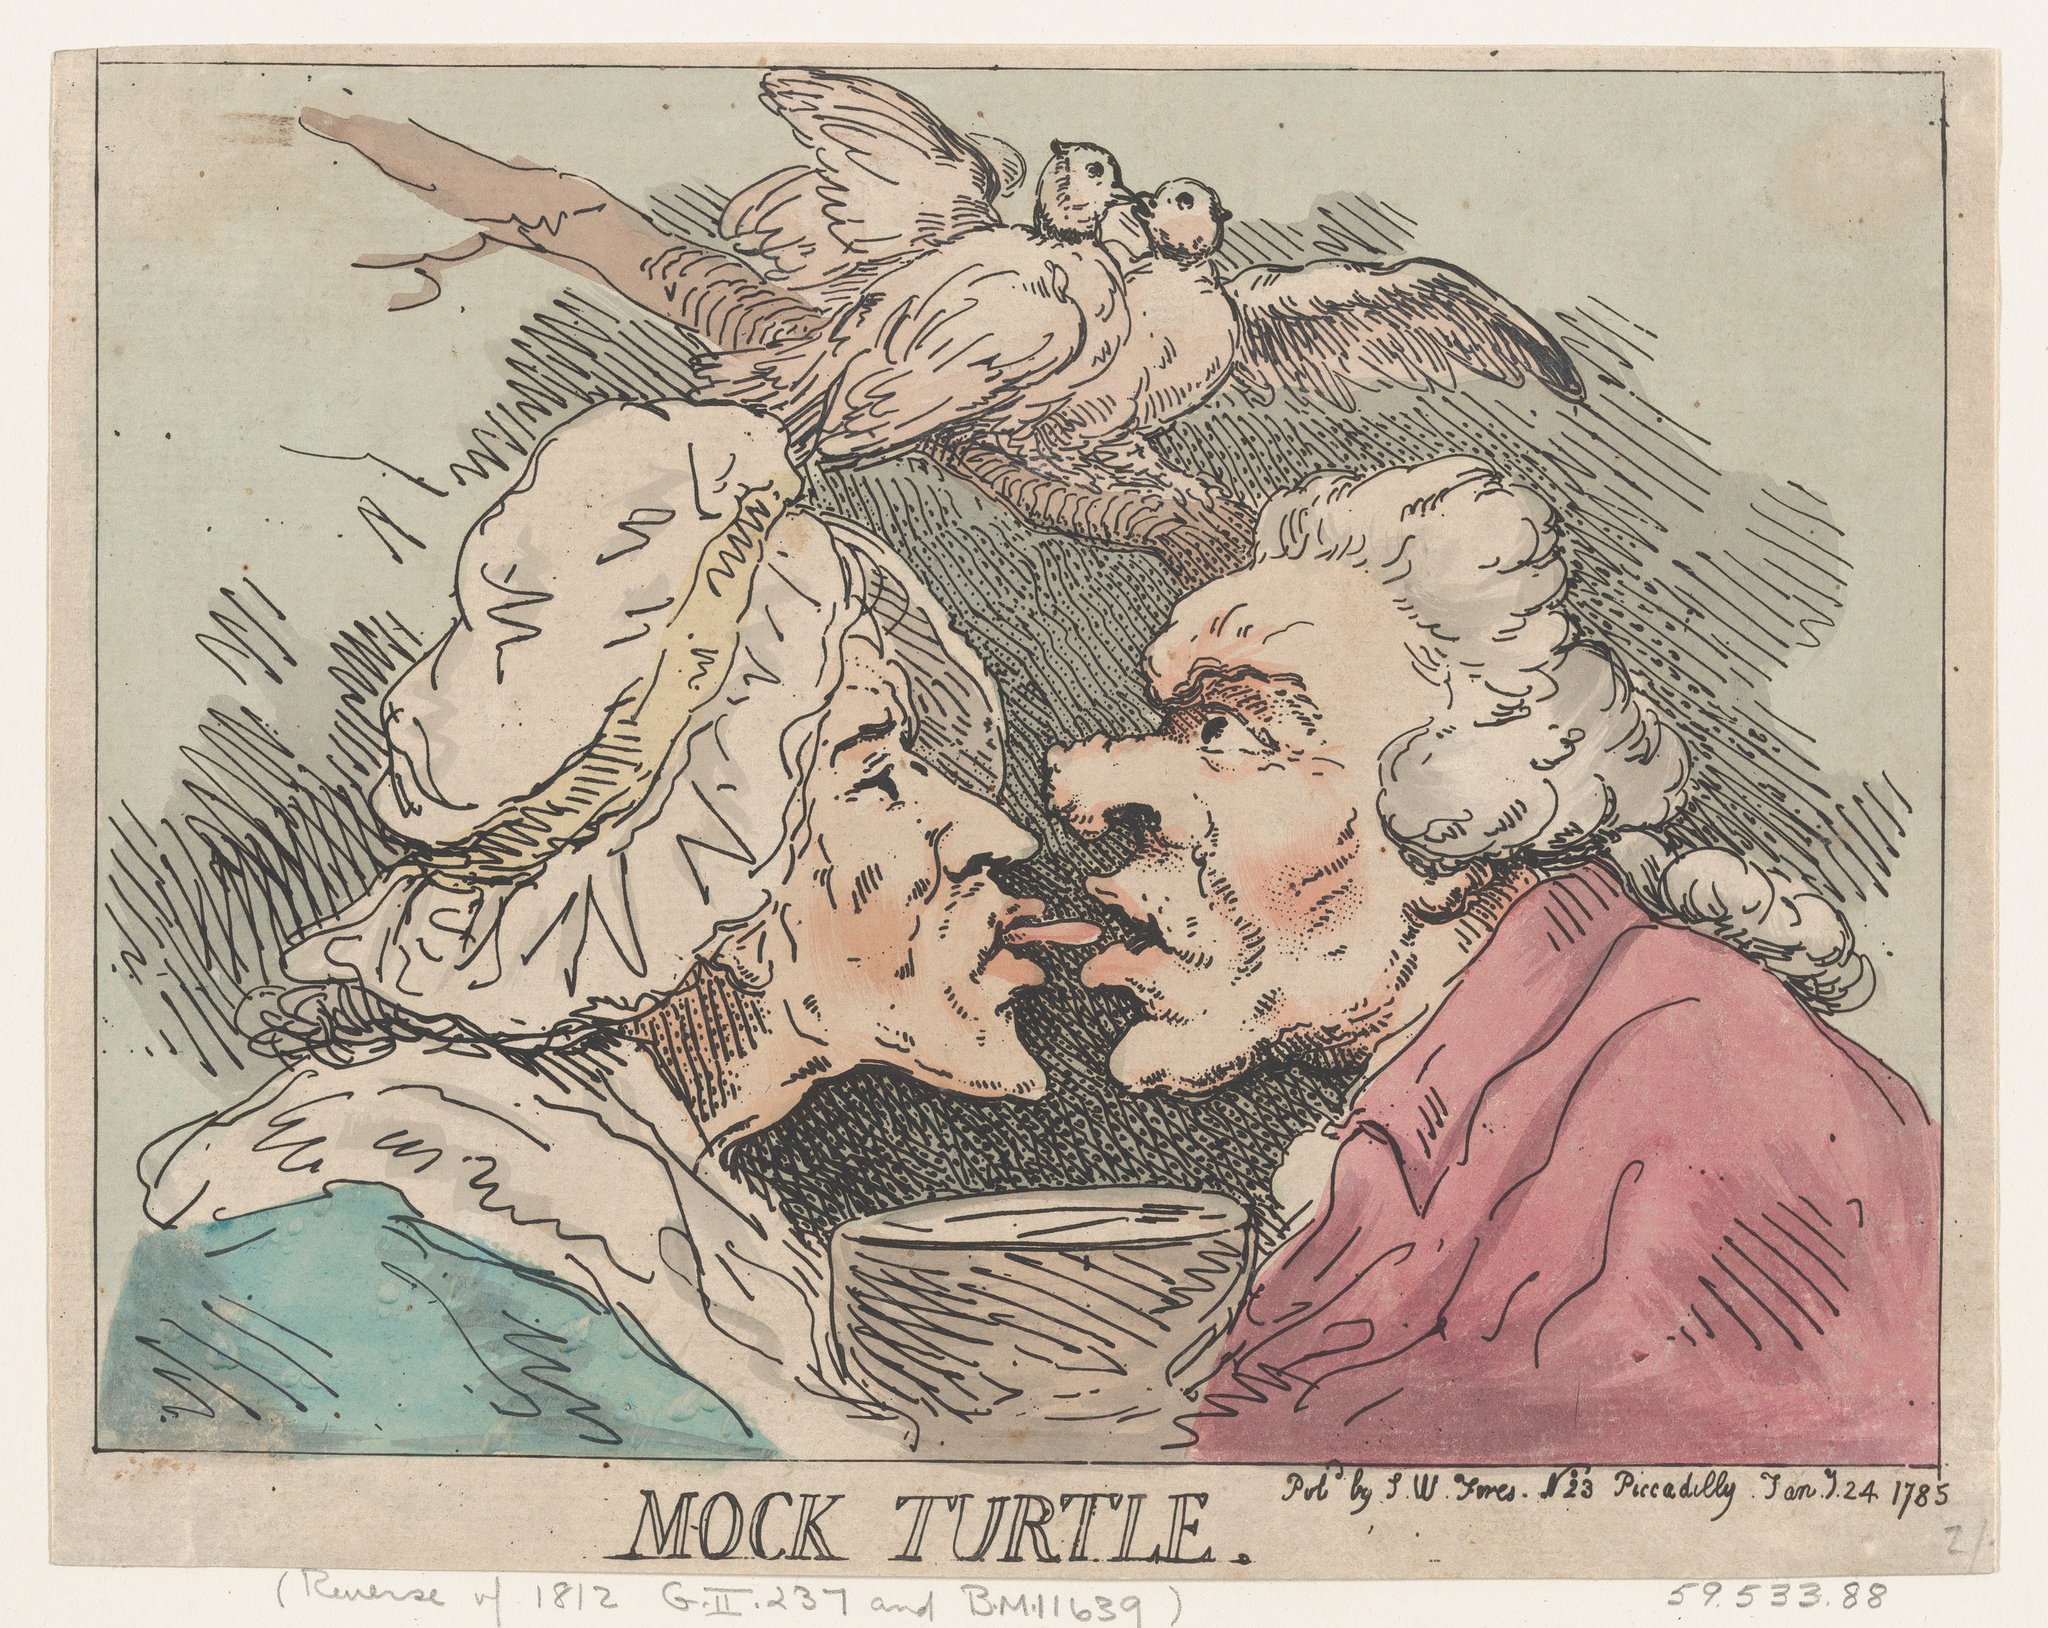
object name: print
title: Mock Turtle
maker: thomas rowlandson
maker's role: artist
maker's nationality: british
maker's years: 1757-1827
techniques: etching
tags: birds,men,women